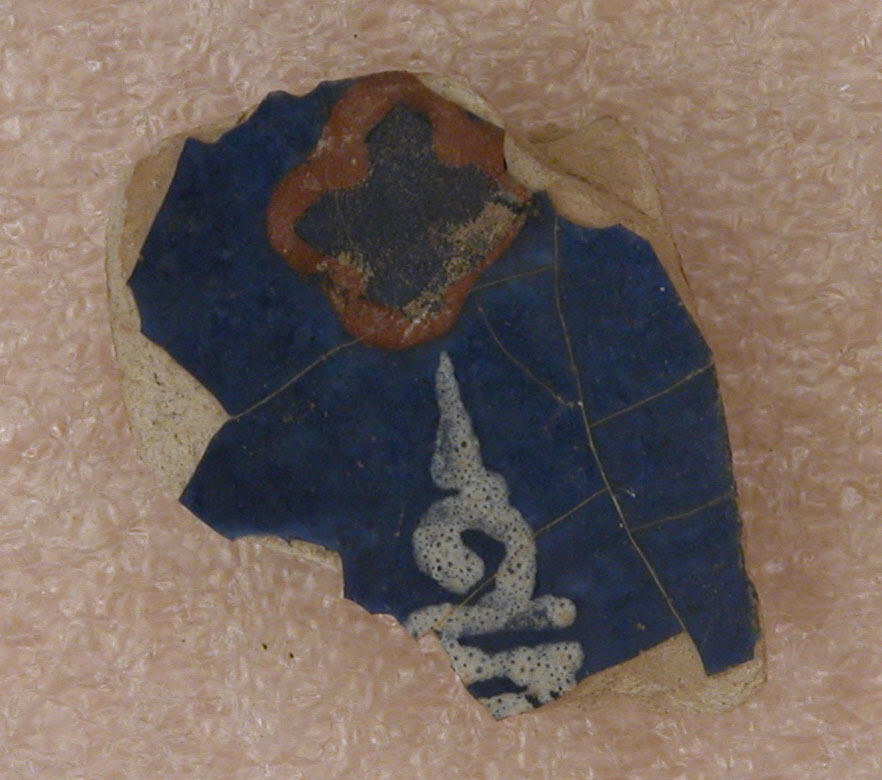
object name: tile fragment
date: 1334-1434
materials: glaze, stonepaste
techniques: painting, polychrome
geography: uzbekistan